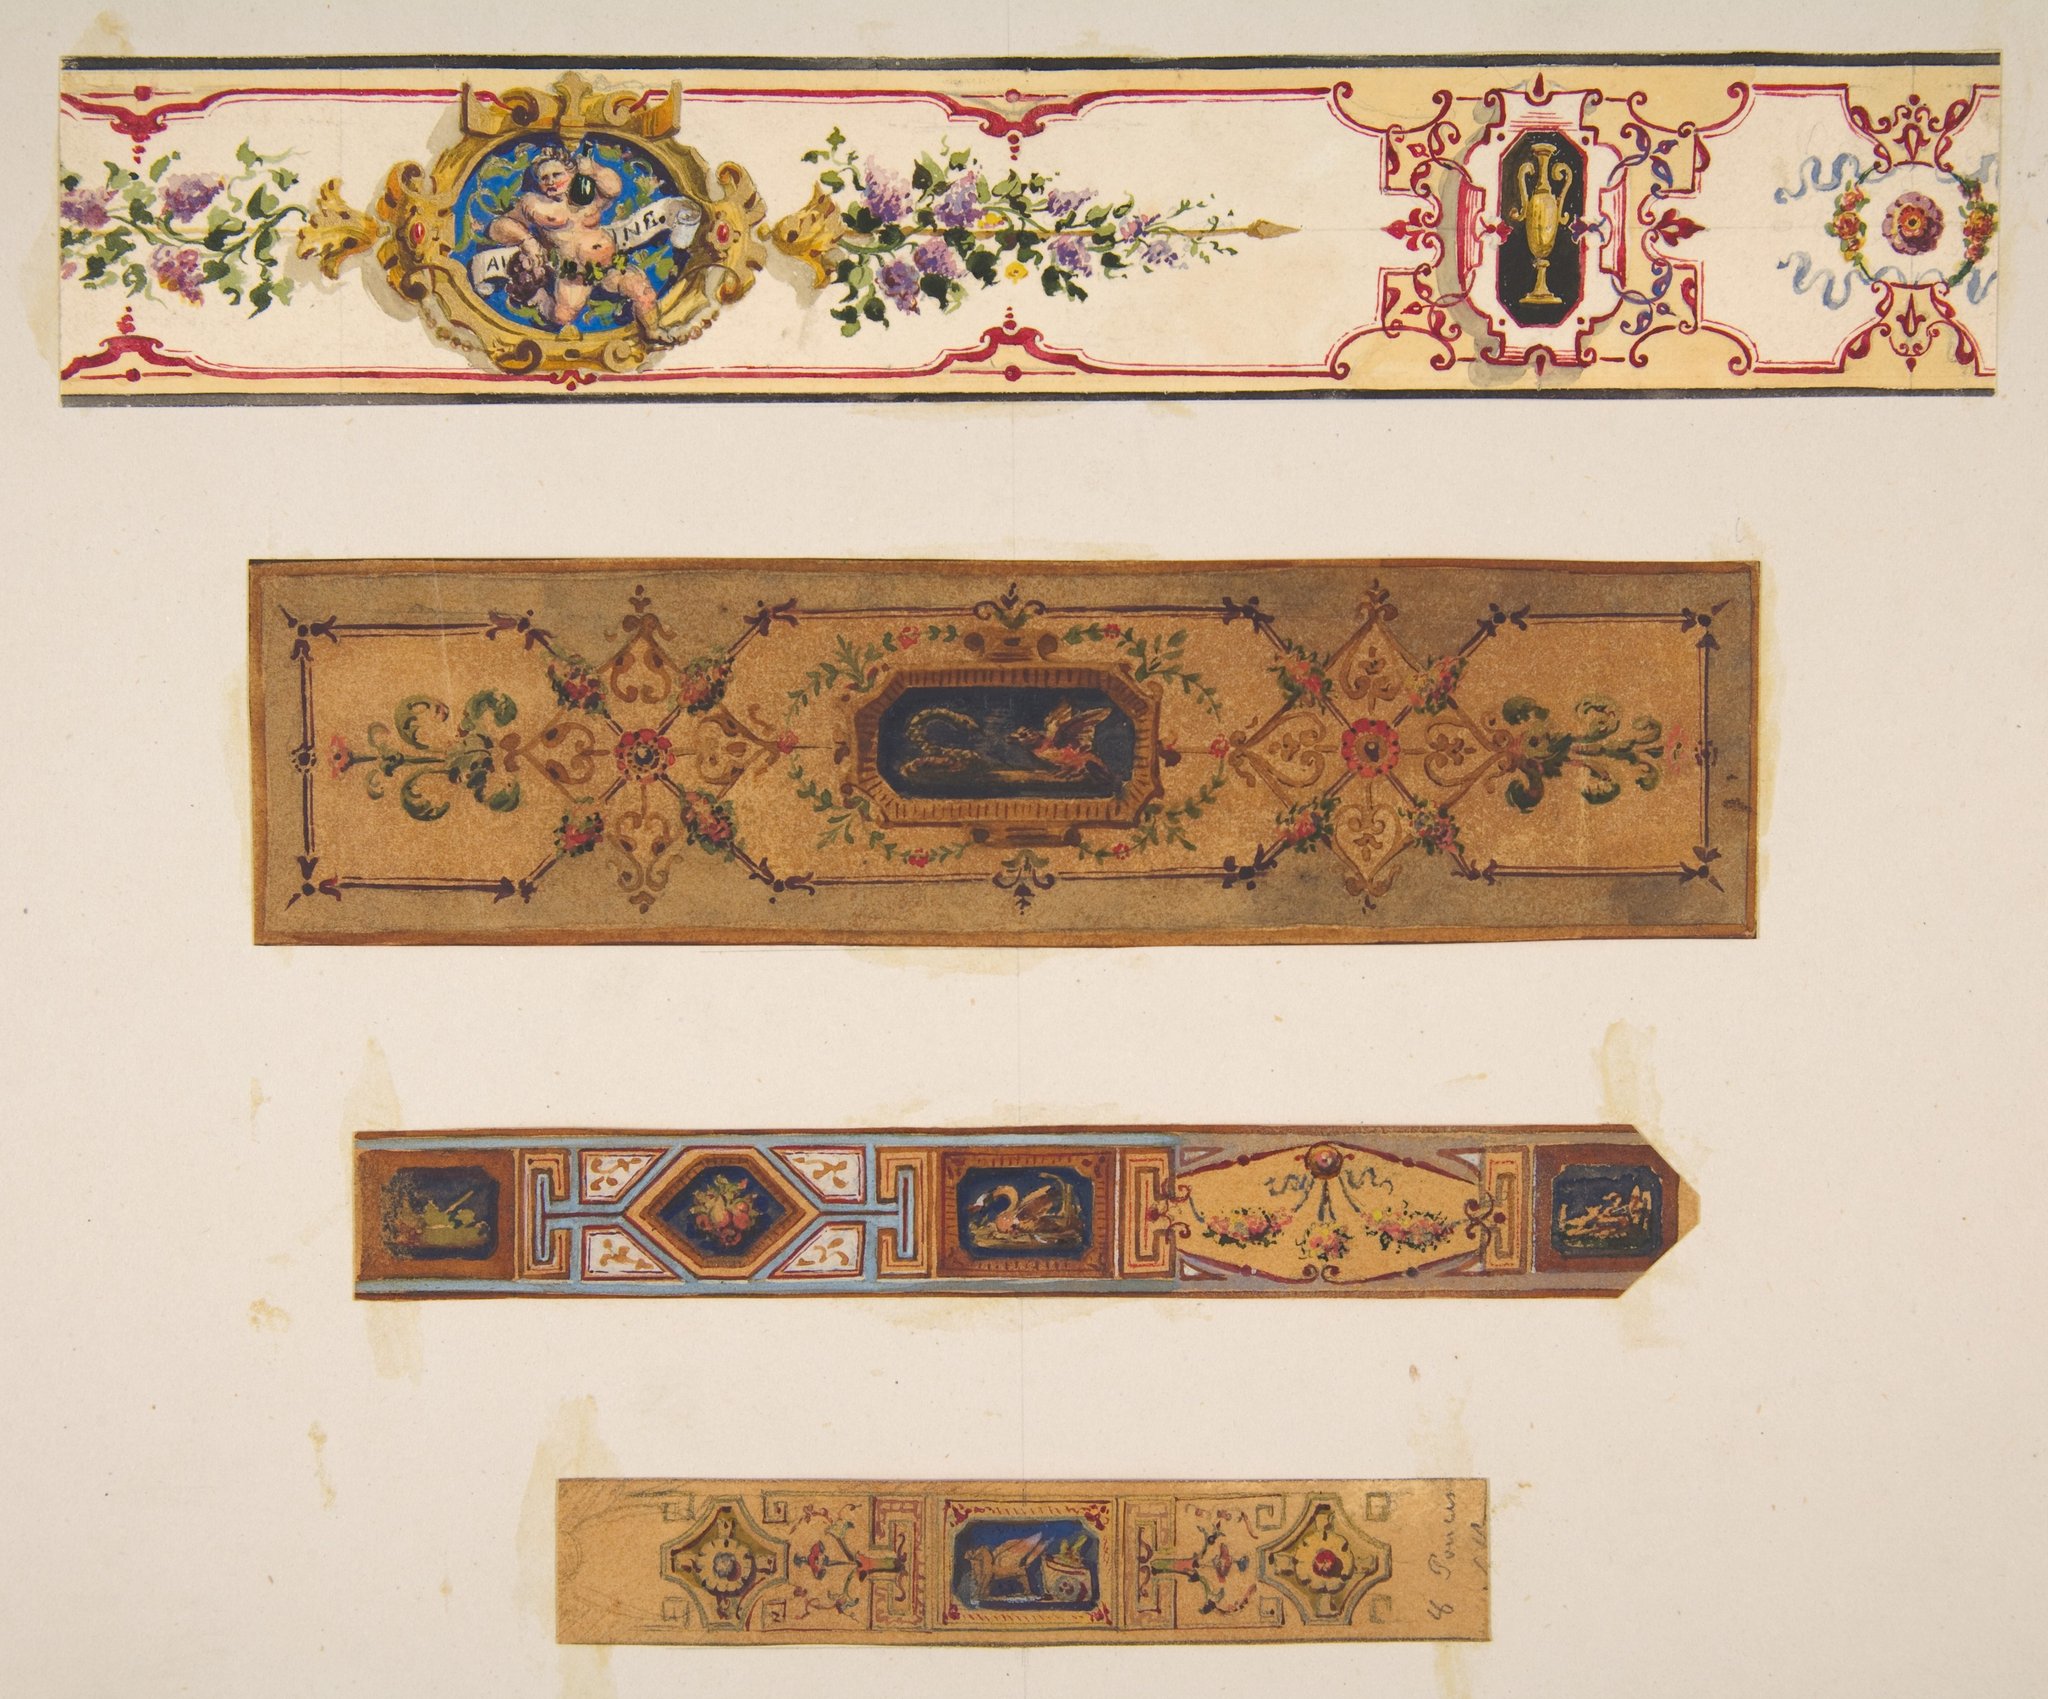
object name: drawing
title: Four designs for painted borders to decorate a room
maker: jules-edmond-charles lachaise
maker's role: artist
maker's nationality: french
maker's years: 1897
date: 1801-1900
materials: gouache, ink, paper, watercolor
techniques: pen